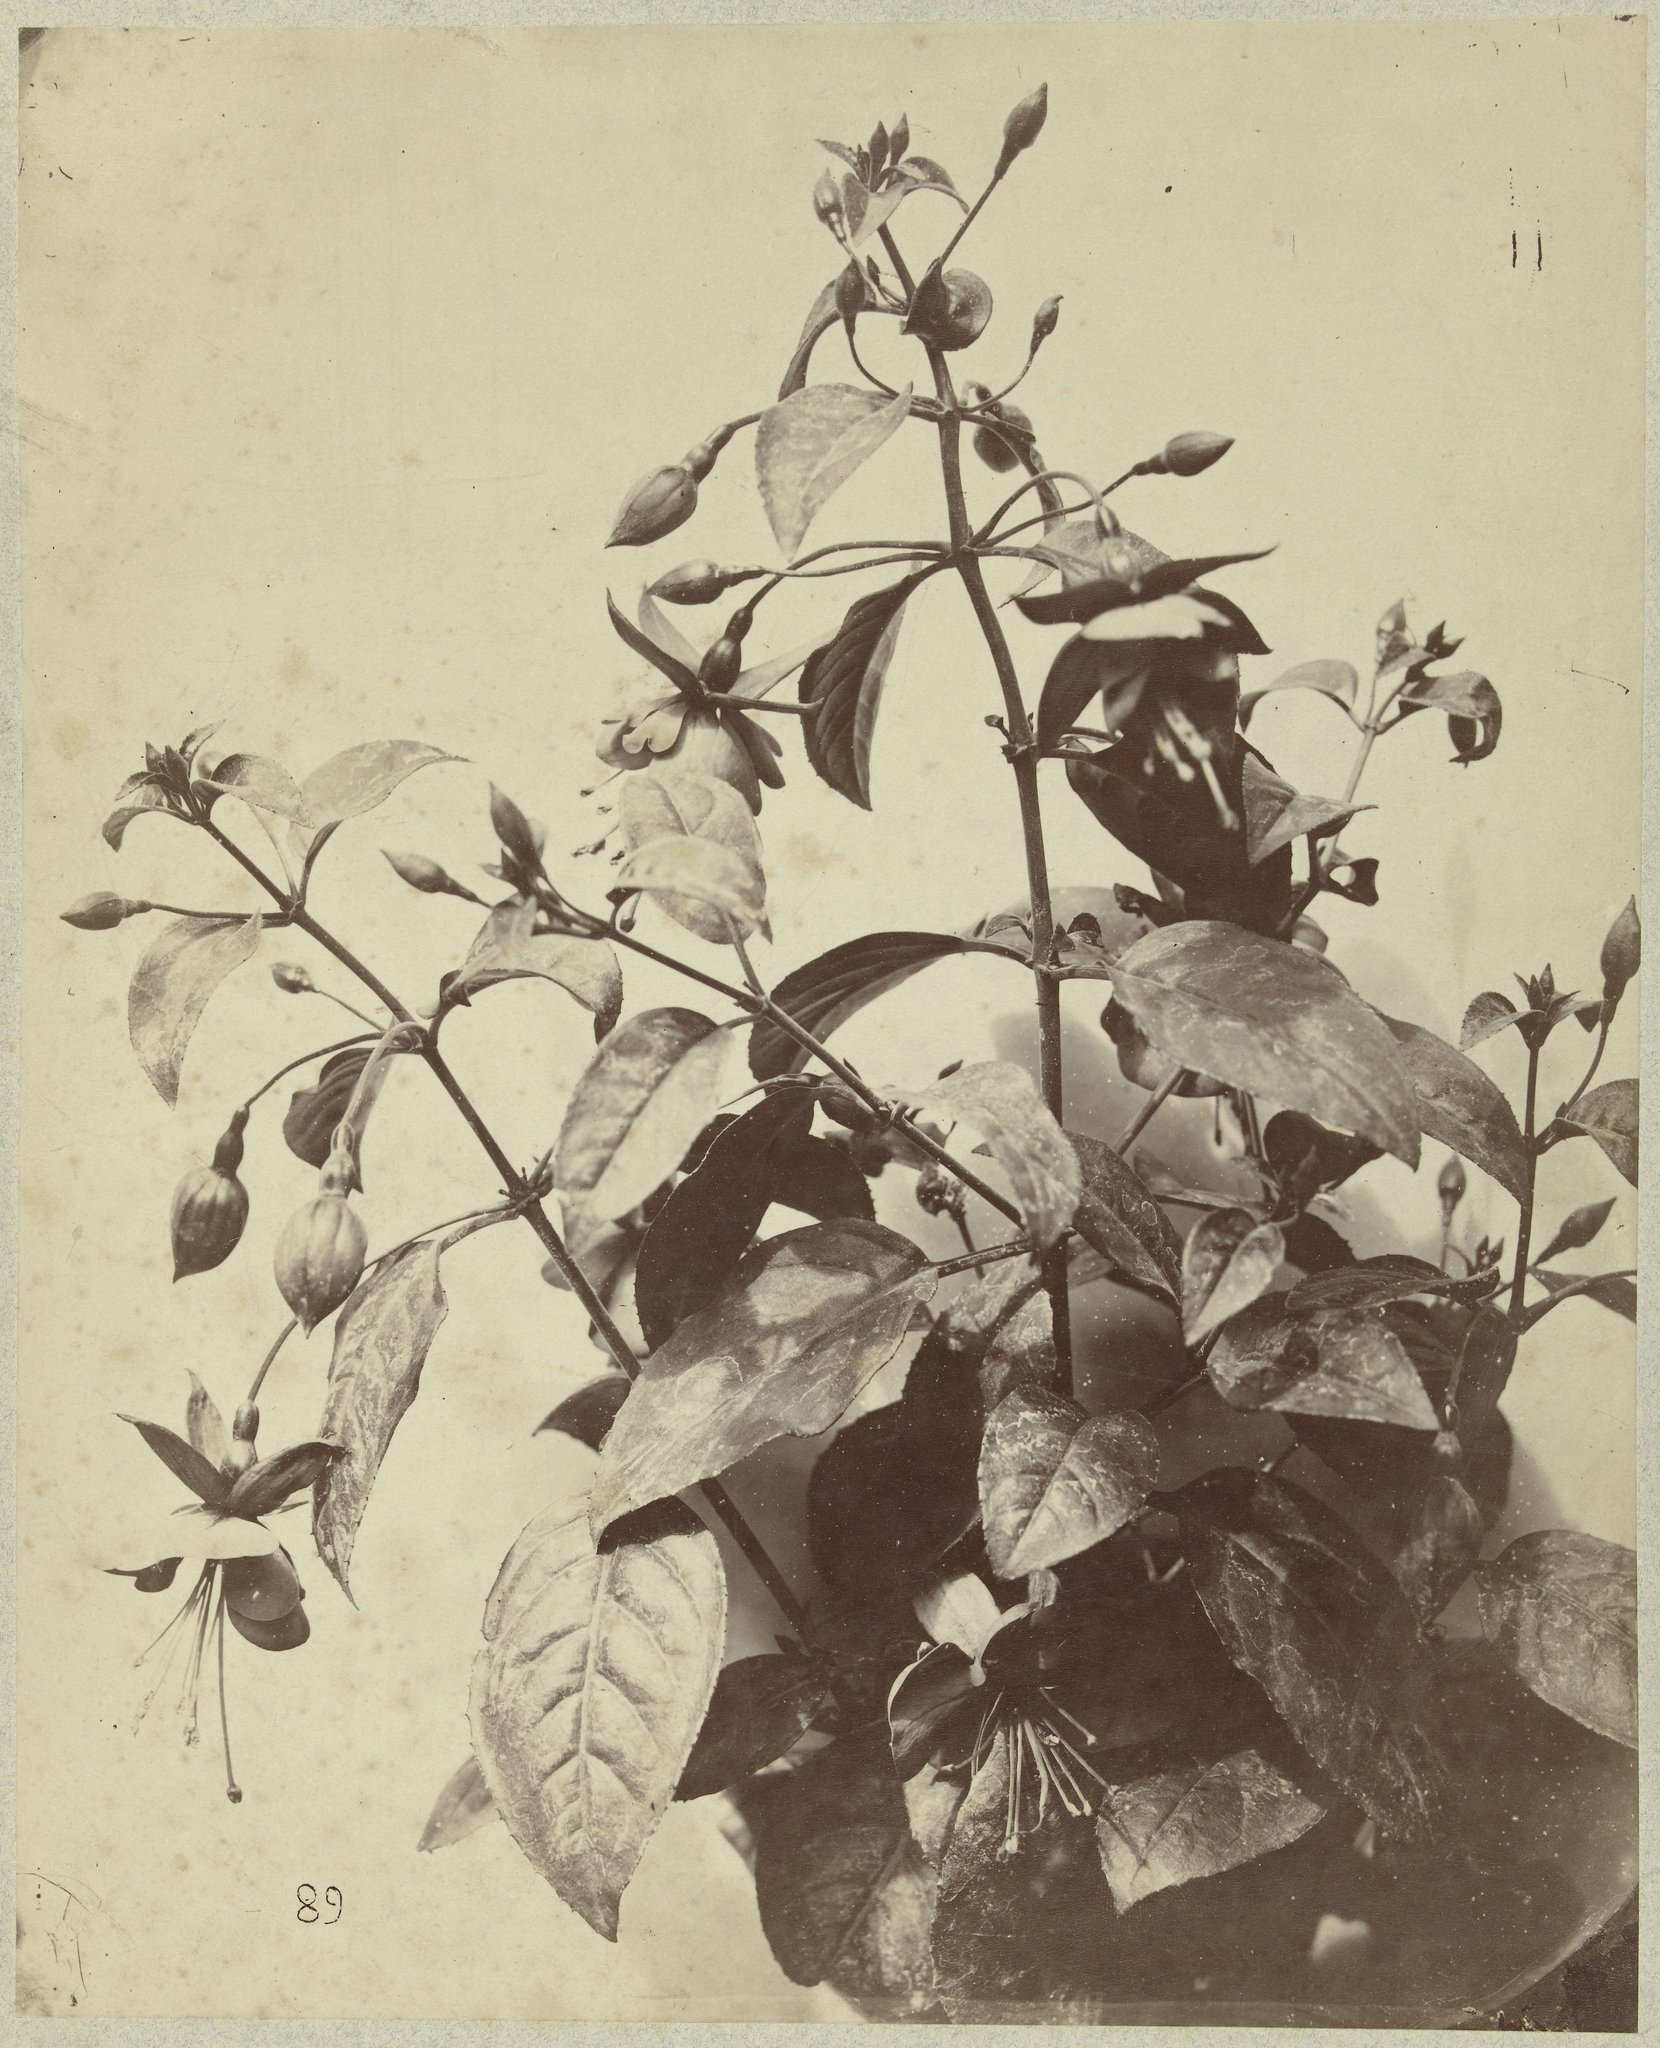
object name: photograph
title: Bloemstilleven met fuchsia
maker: charles aubry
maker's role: fotograaf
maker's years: 1811-1877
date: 1864-1872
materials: cardboard, paper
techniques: albumen print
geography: paris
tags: flowers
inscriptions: number: ‘89’